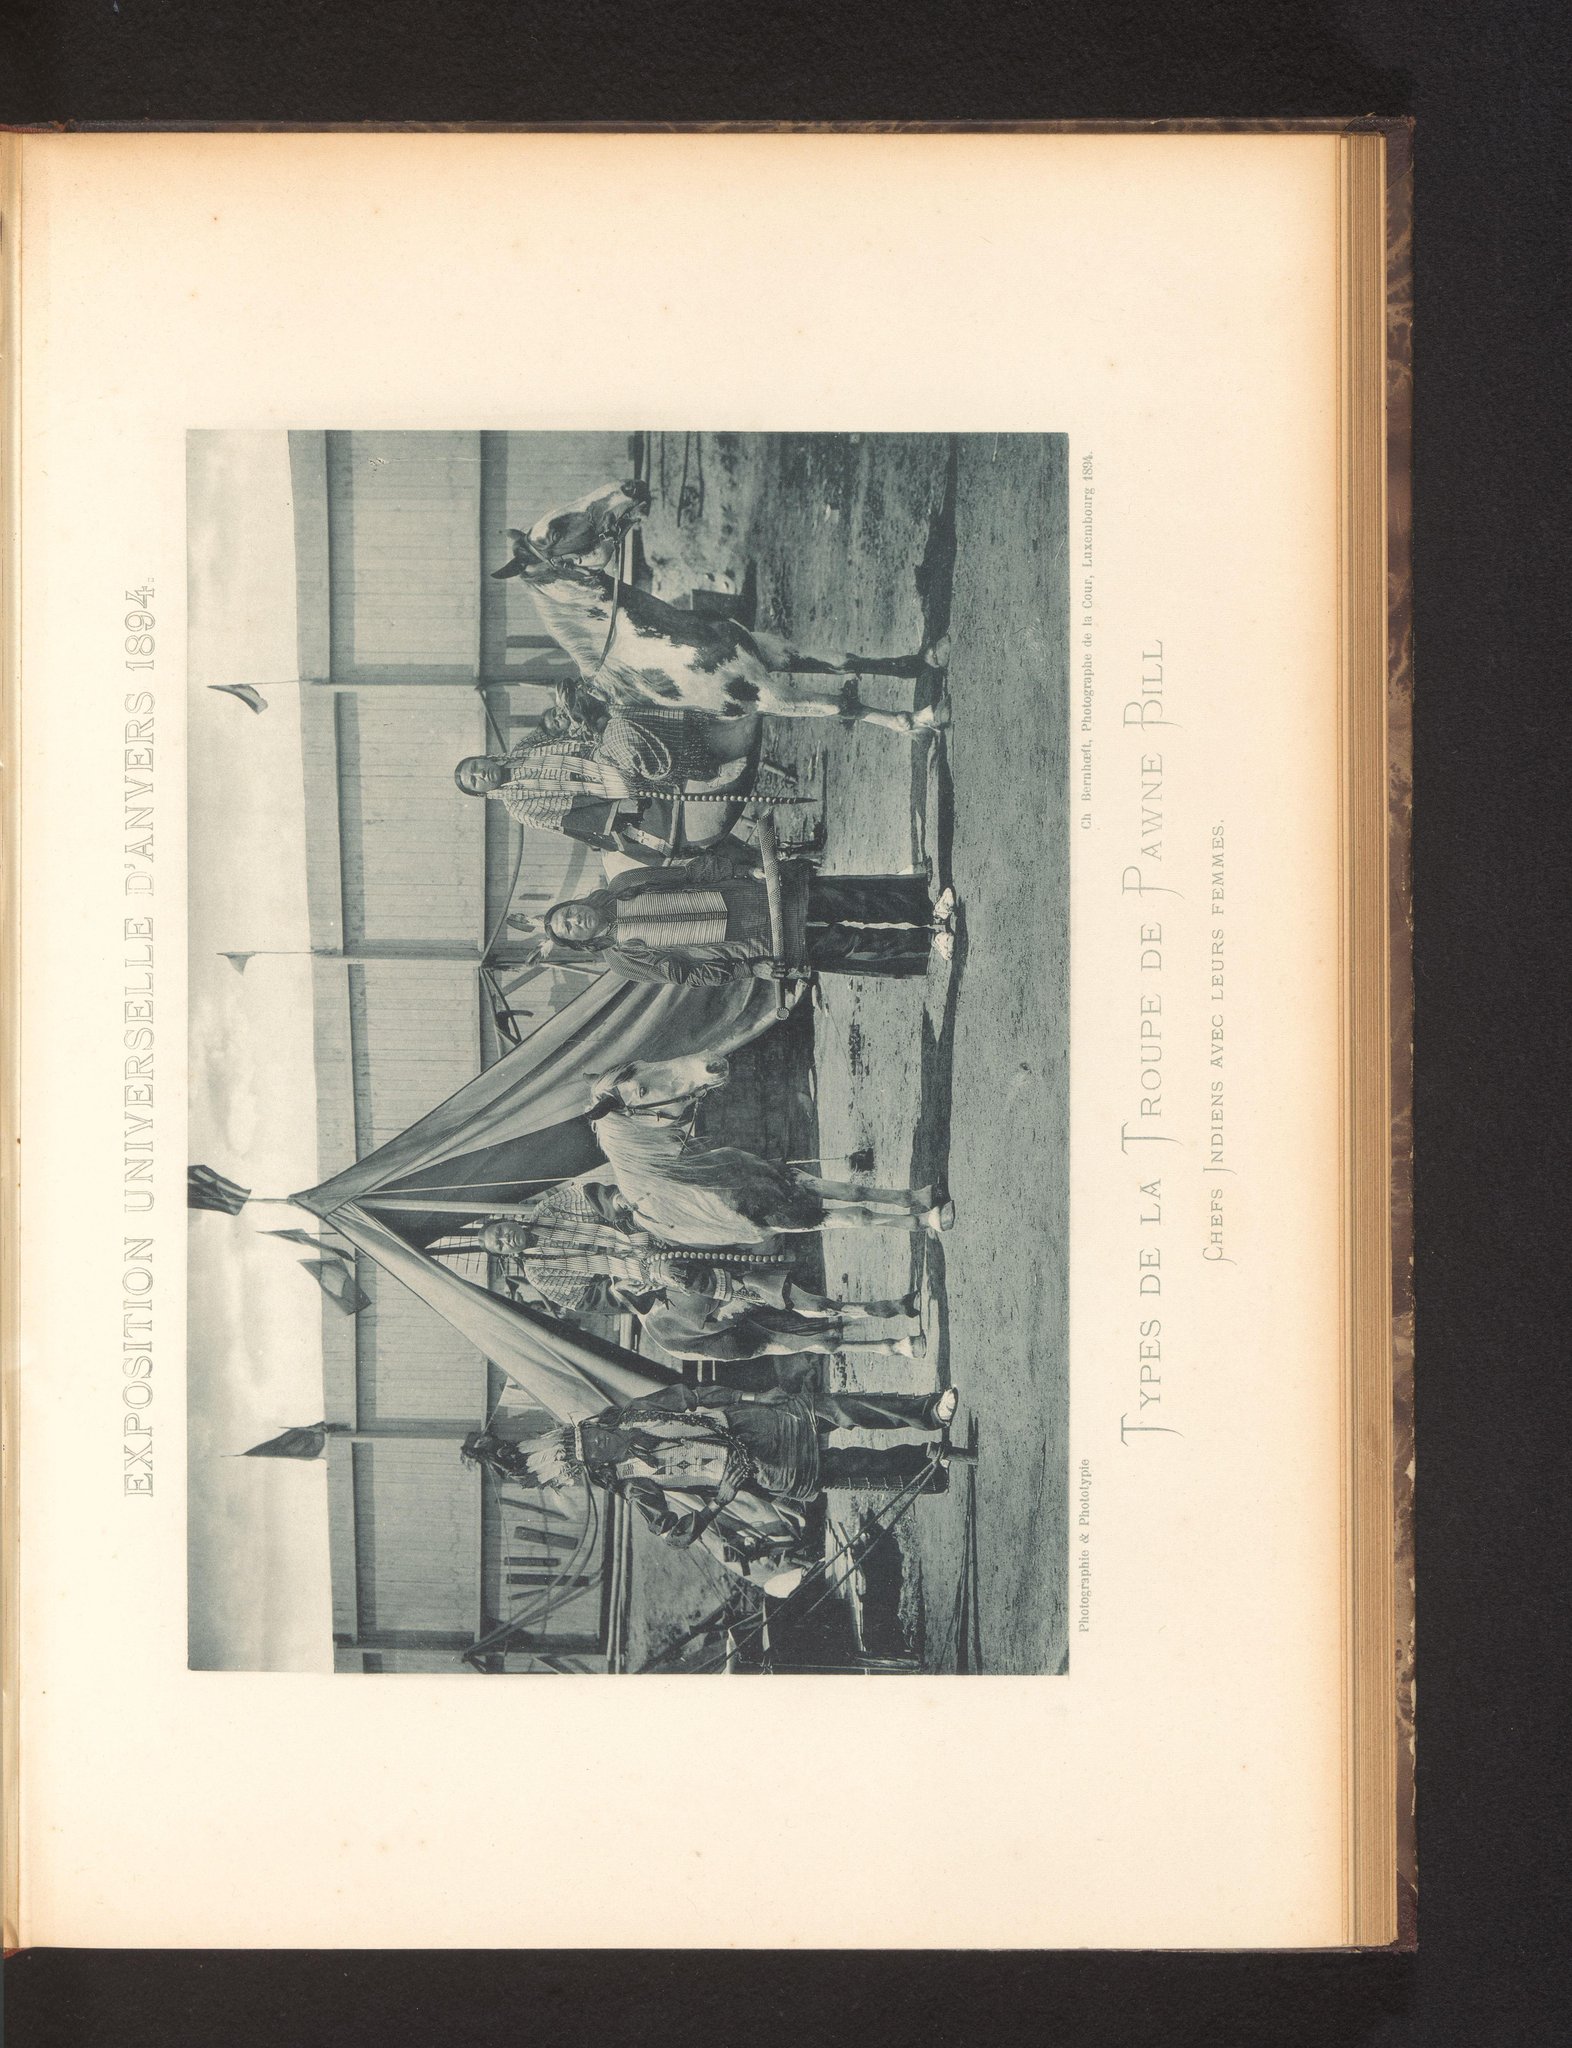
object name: page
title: Exposition Universelle d'Anvers 1894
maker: charles bernhoeft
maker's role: publisher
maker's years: 1859-1933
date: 1894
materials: paper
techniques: photograph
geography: antwerp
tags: world fair, world exhibition, indigenous peoples of north america, horse, antwerp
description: Prent op derde ongenummerde pagina na pagina 62.